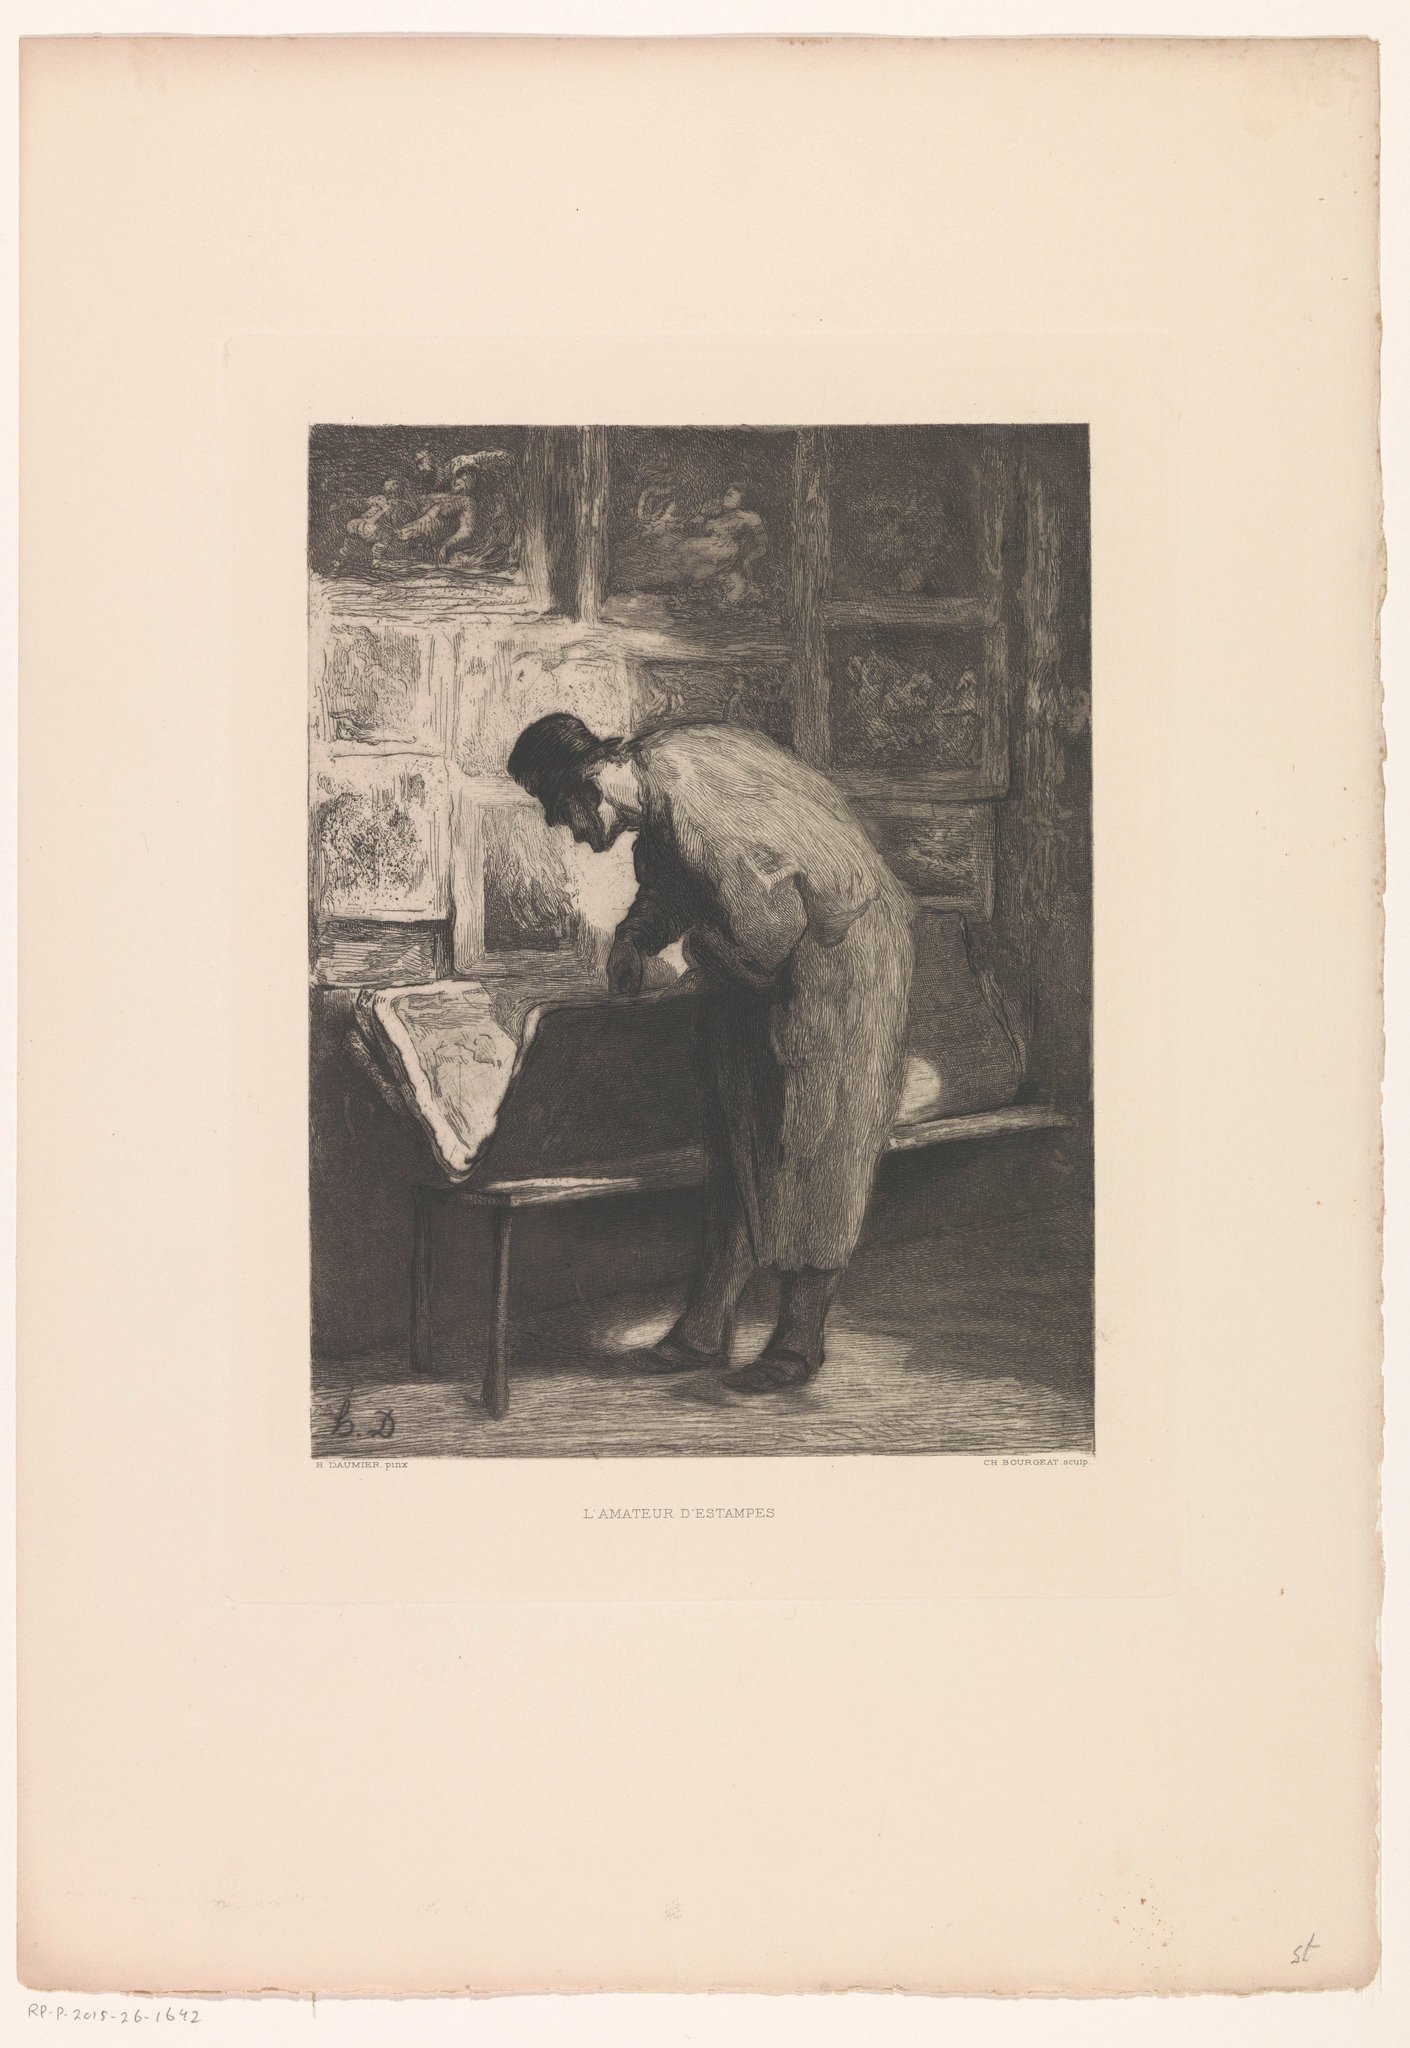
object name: print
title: Verzamelaar van prenten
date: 1888-1945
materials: paper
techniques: etching, intaglio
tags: print, e.g.: engraving, etching, lithograph, art collector (+ graphic arts)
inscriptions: collector's mark: Lugt 4779, collector's mark: Lugt 2228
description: Een man met bolhoed bladert door een map met prenten. Aan de muur hangen prenten.